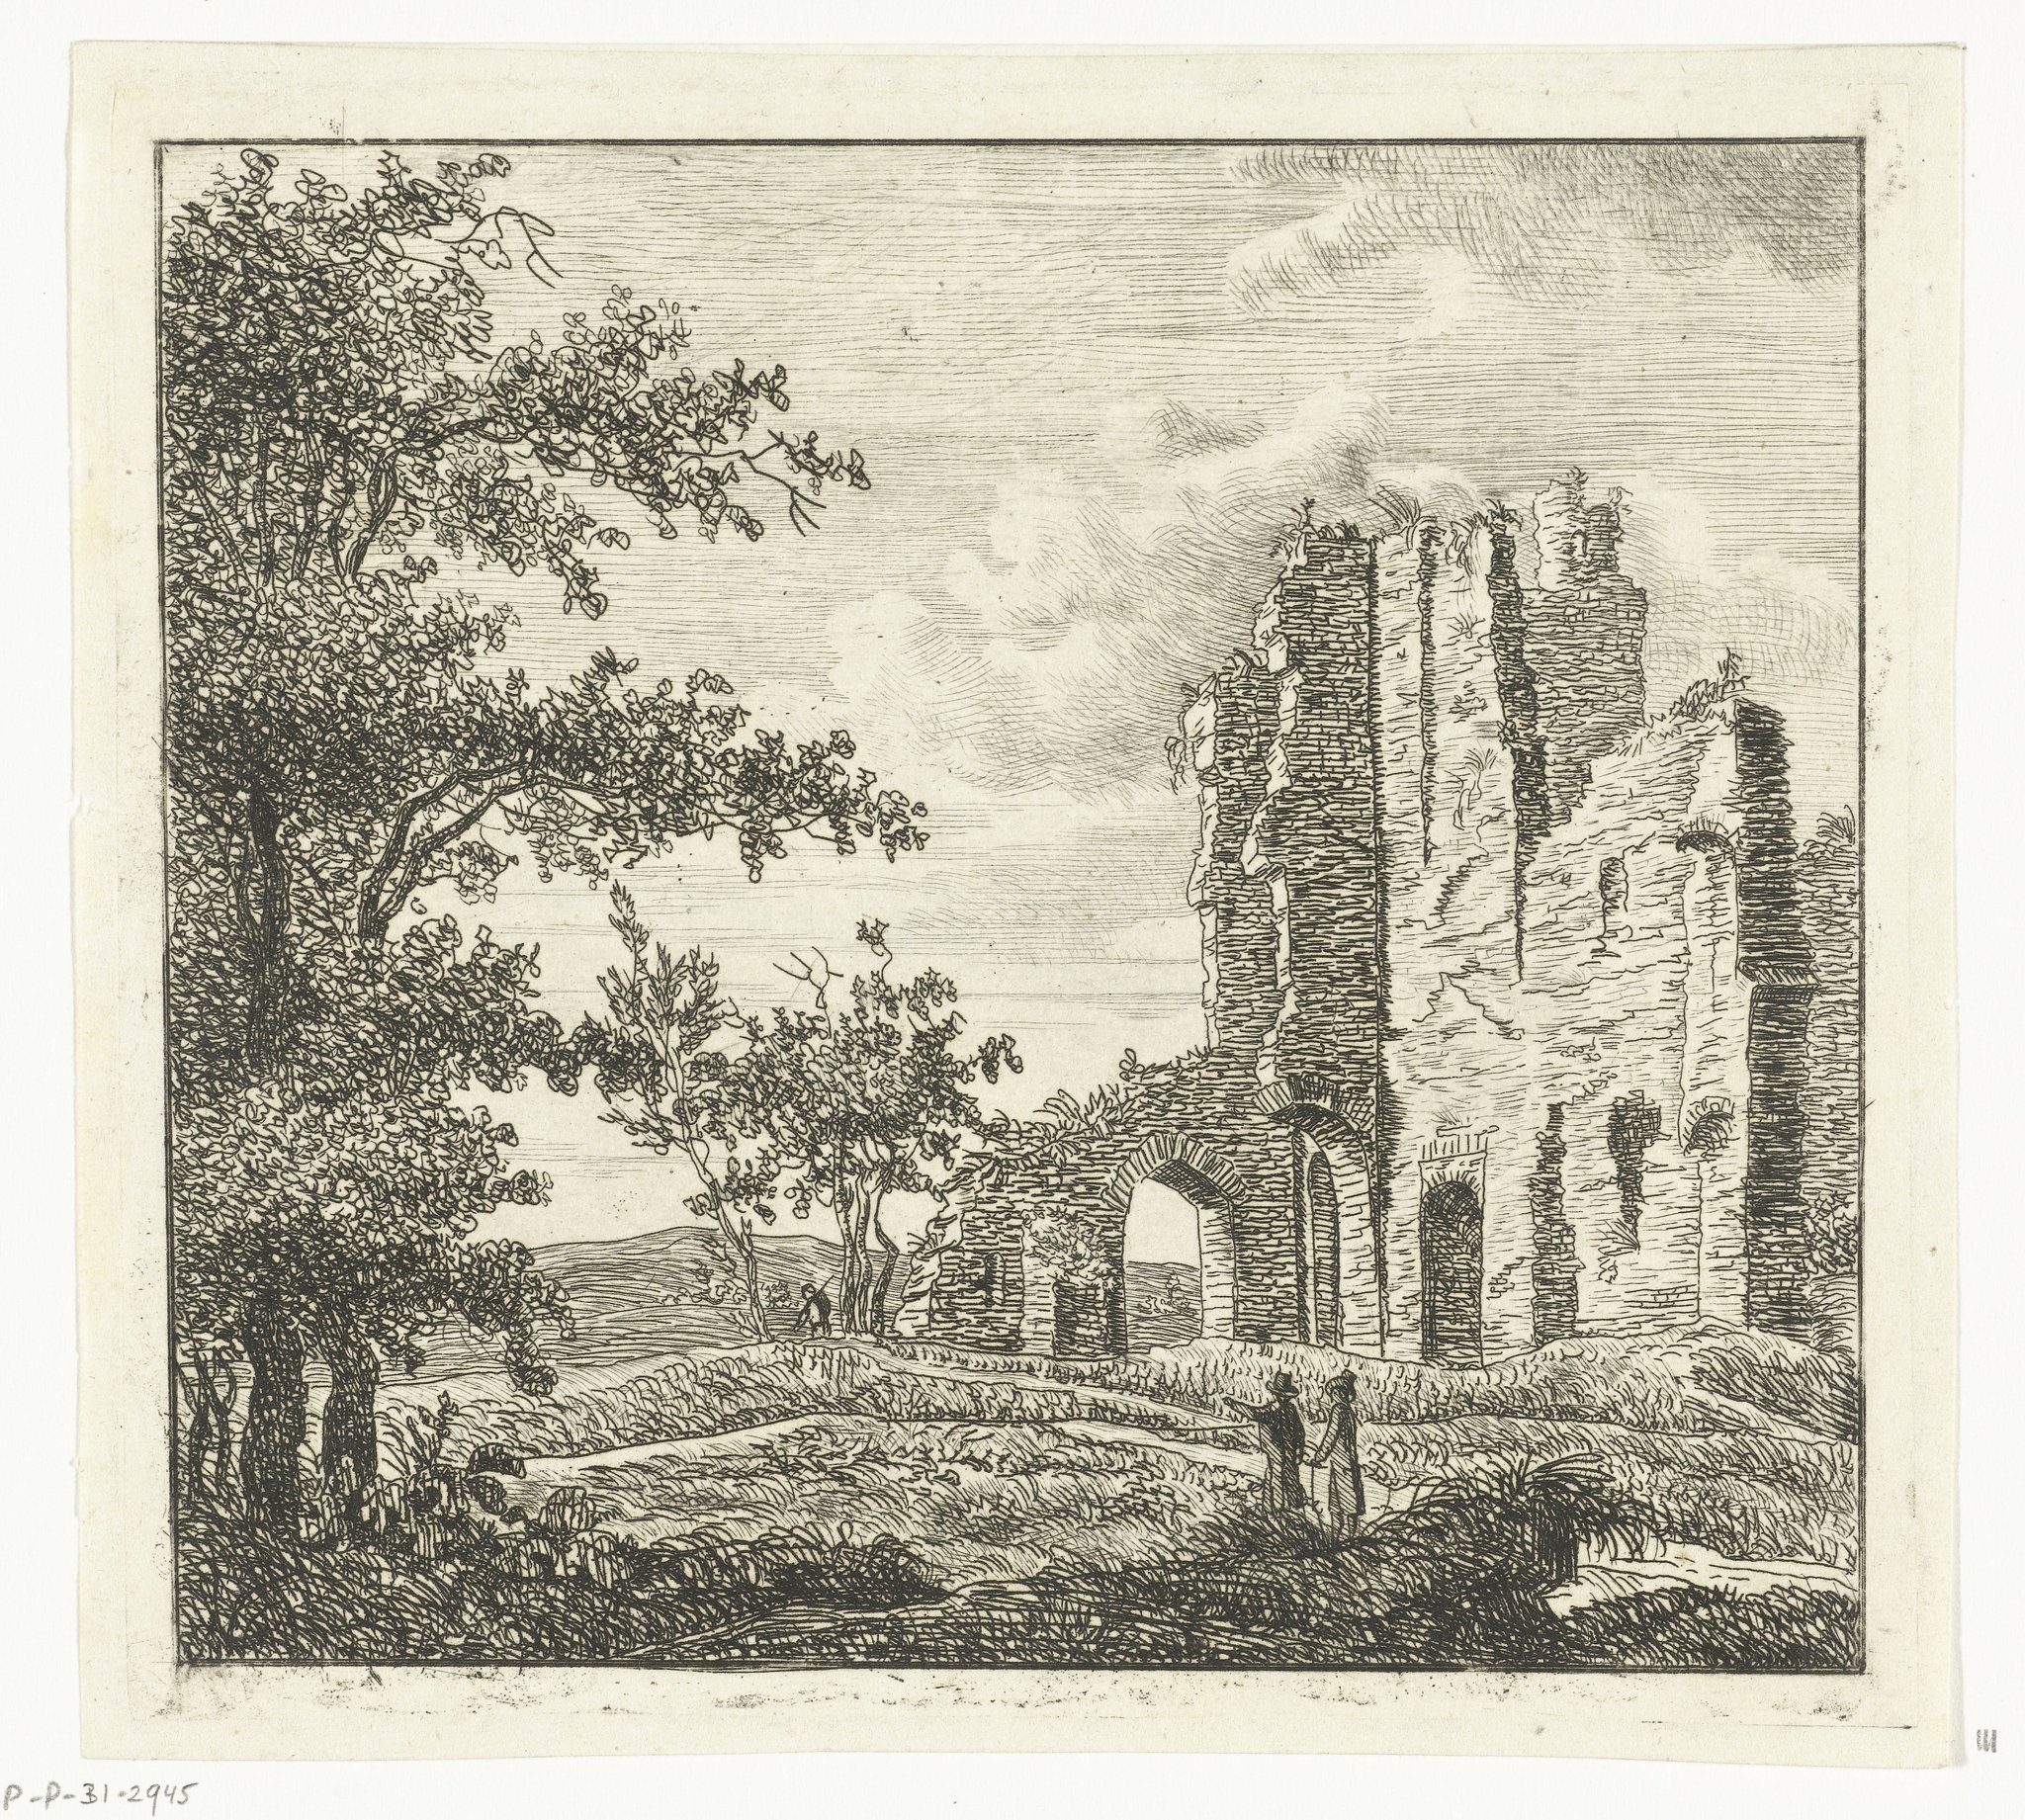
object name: print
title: Ruïne van Brederode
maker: anthonie van den bos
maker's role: draughtsman, print maker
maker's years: 1763-1838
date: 1778-1838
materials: paper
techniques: etching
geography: netherlands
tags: ruin of a dwelling, house, castle, etc.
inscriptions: collector's mark: Lugt 2228